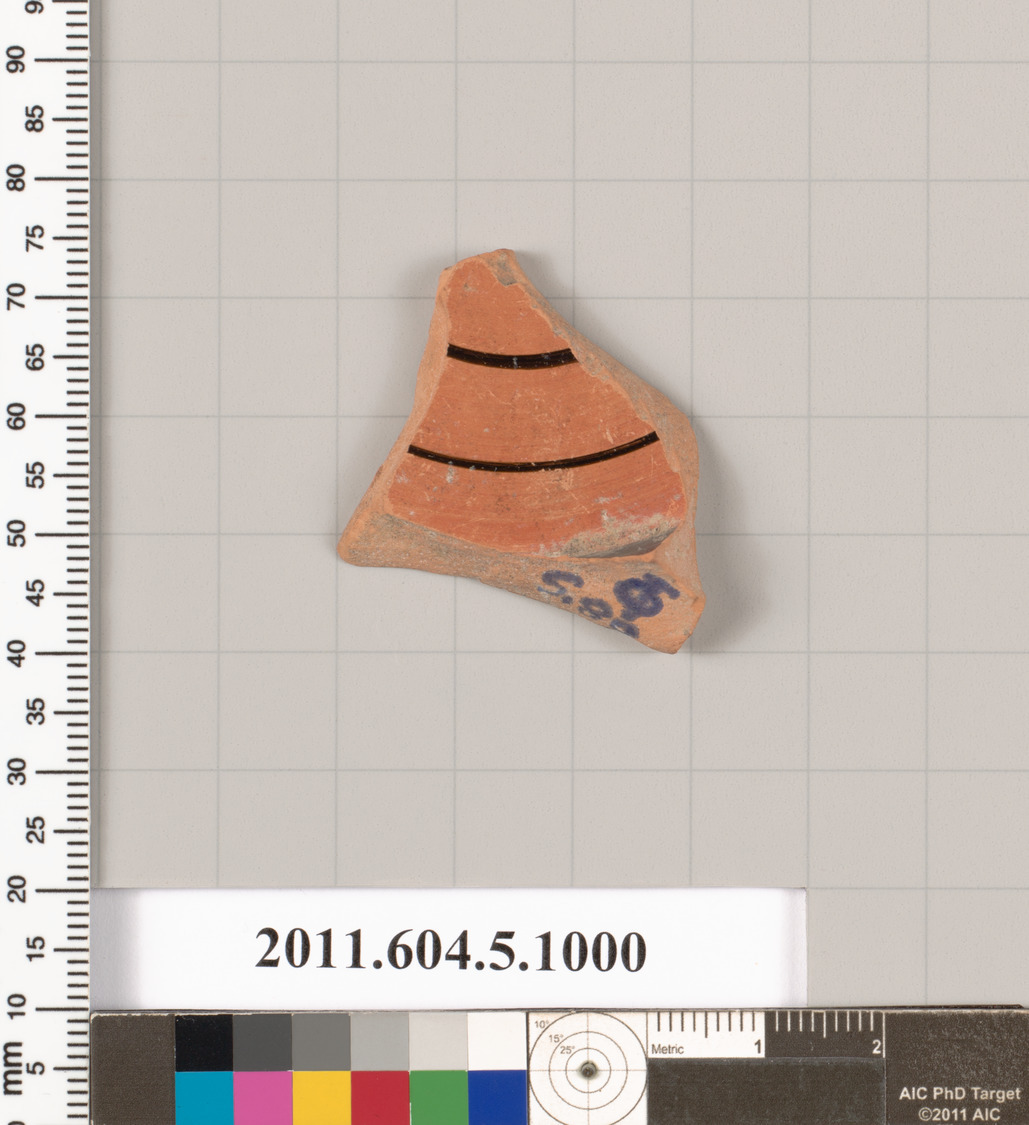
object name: kylix fragment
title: Terracotta fragment of a kylix (drinking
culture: greek, attic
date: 600-401 BCE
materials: terracotta